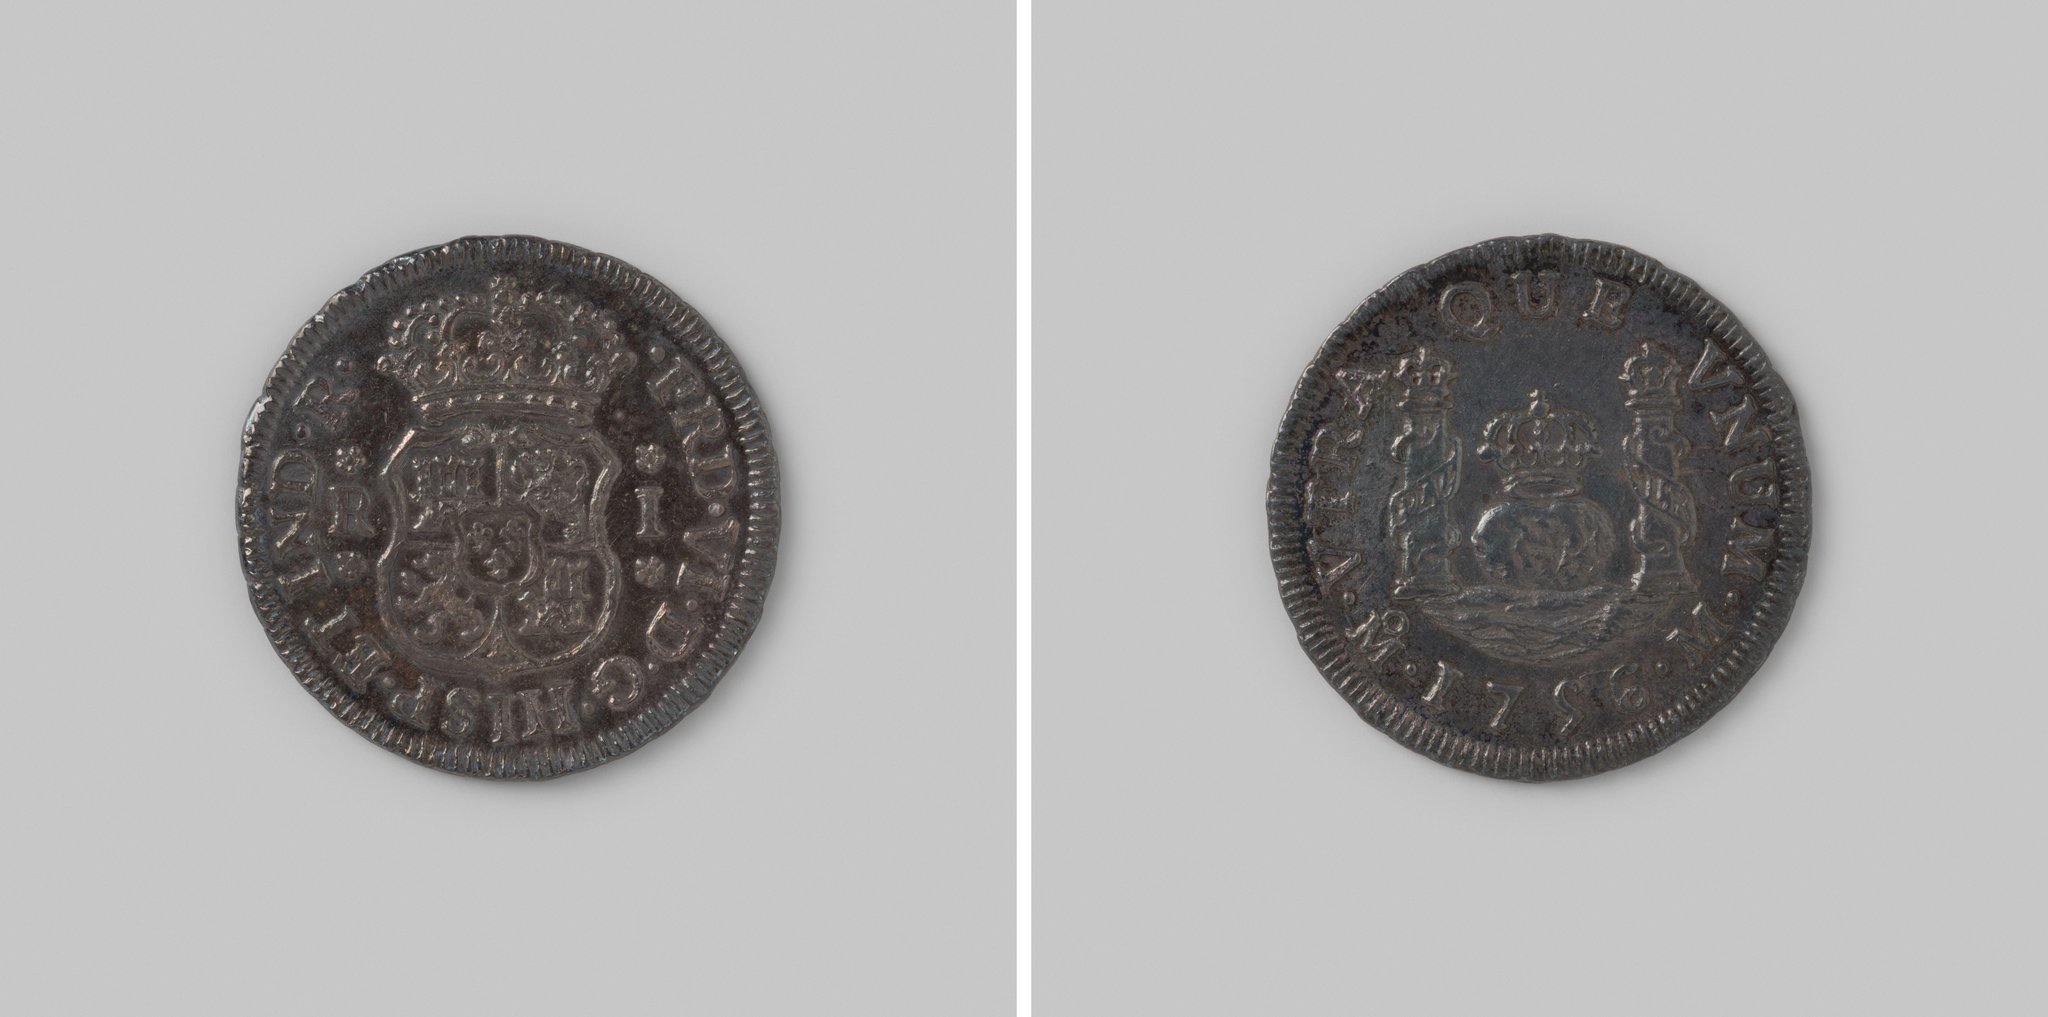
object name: real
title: Mexico, koning Ferdinand VI, reaal,1756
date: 1756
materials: silver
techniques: striking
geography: mexico city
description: Zilveren munt. Voorzijde: tussen waarde-aanduiding r[=reaal] en 1 gekroond samengesteld wapenschild. Keerzijde: tussen twee uit zee oprijzende gekroonde zuilen, waarop banderol met opschrift, twee in elkaar grijpende wereldbollen, waarboven kroon. Jaartal onderaan in omschrift. Links daarvan muntplaats-aanduiding: Mo. Bloemrand.